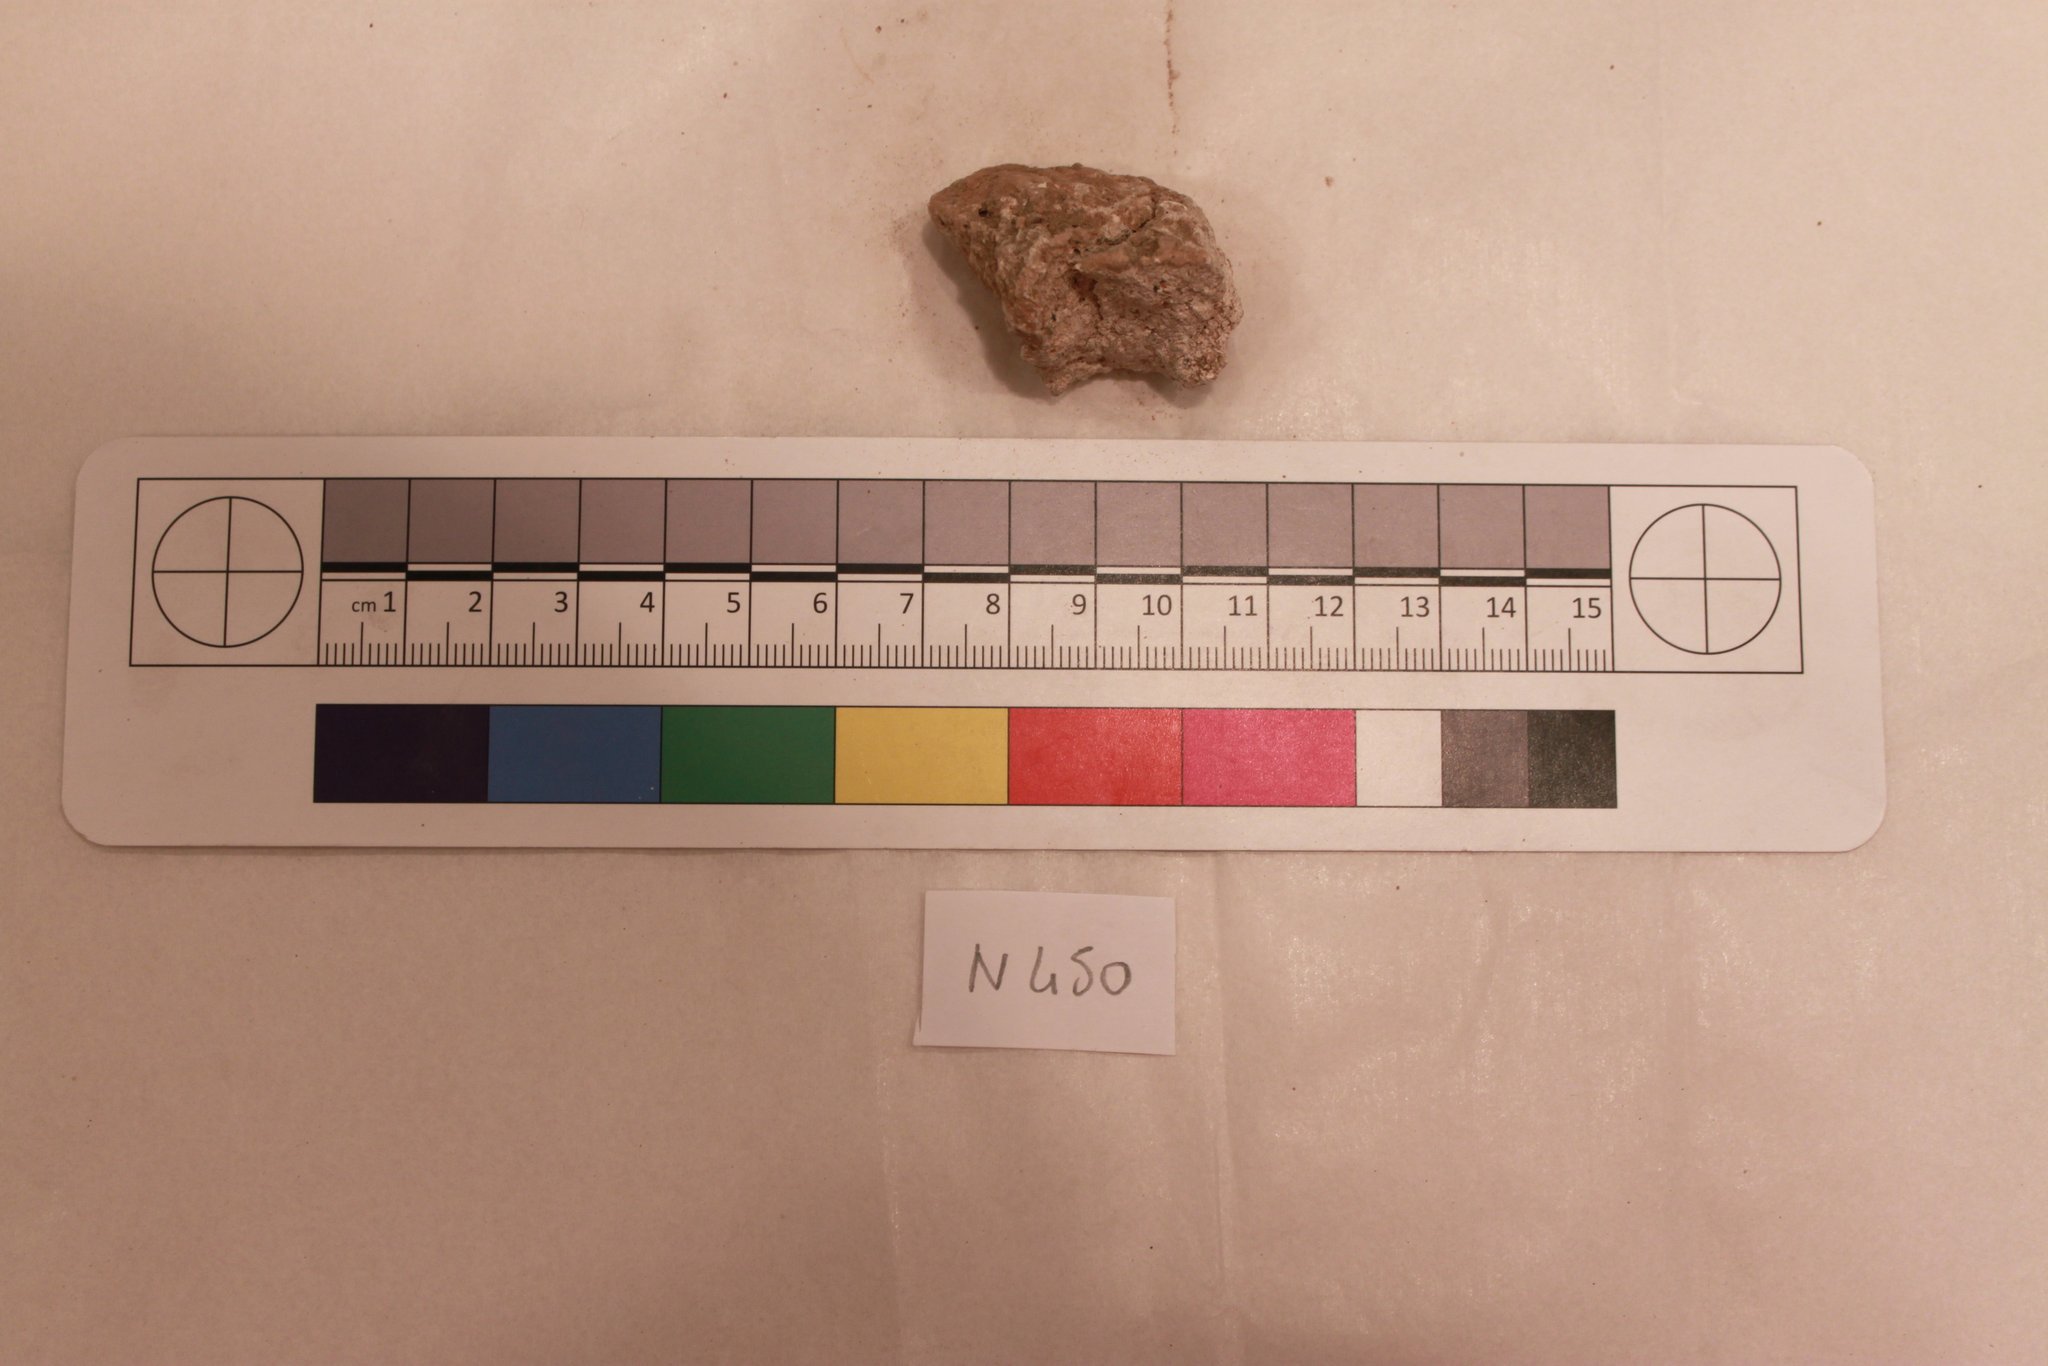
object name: fragment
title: Stucco Fragment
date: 701-1200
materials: plaster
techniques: carving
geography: iran